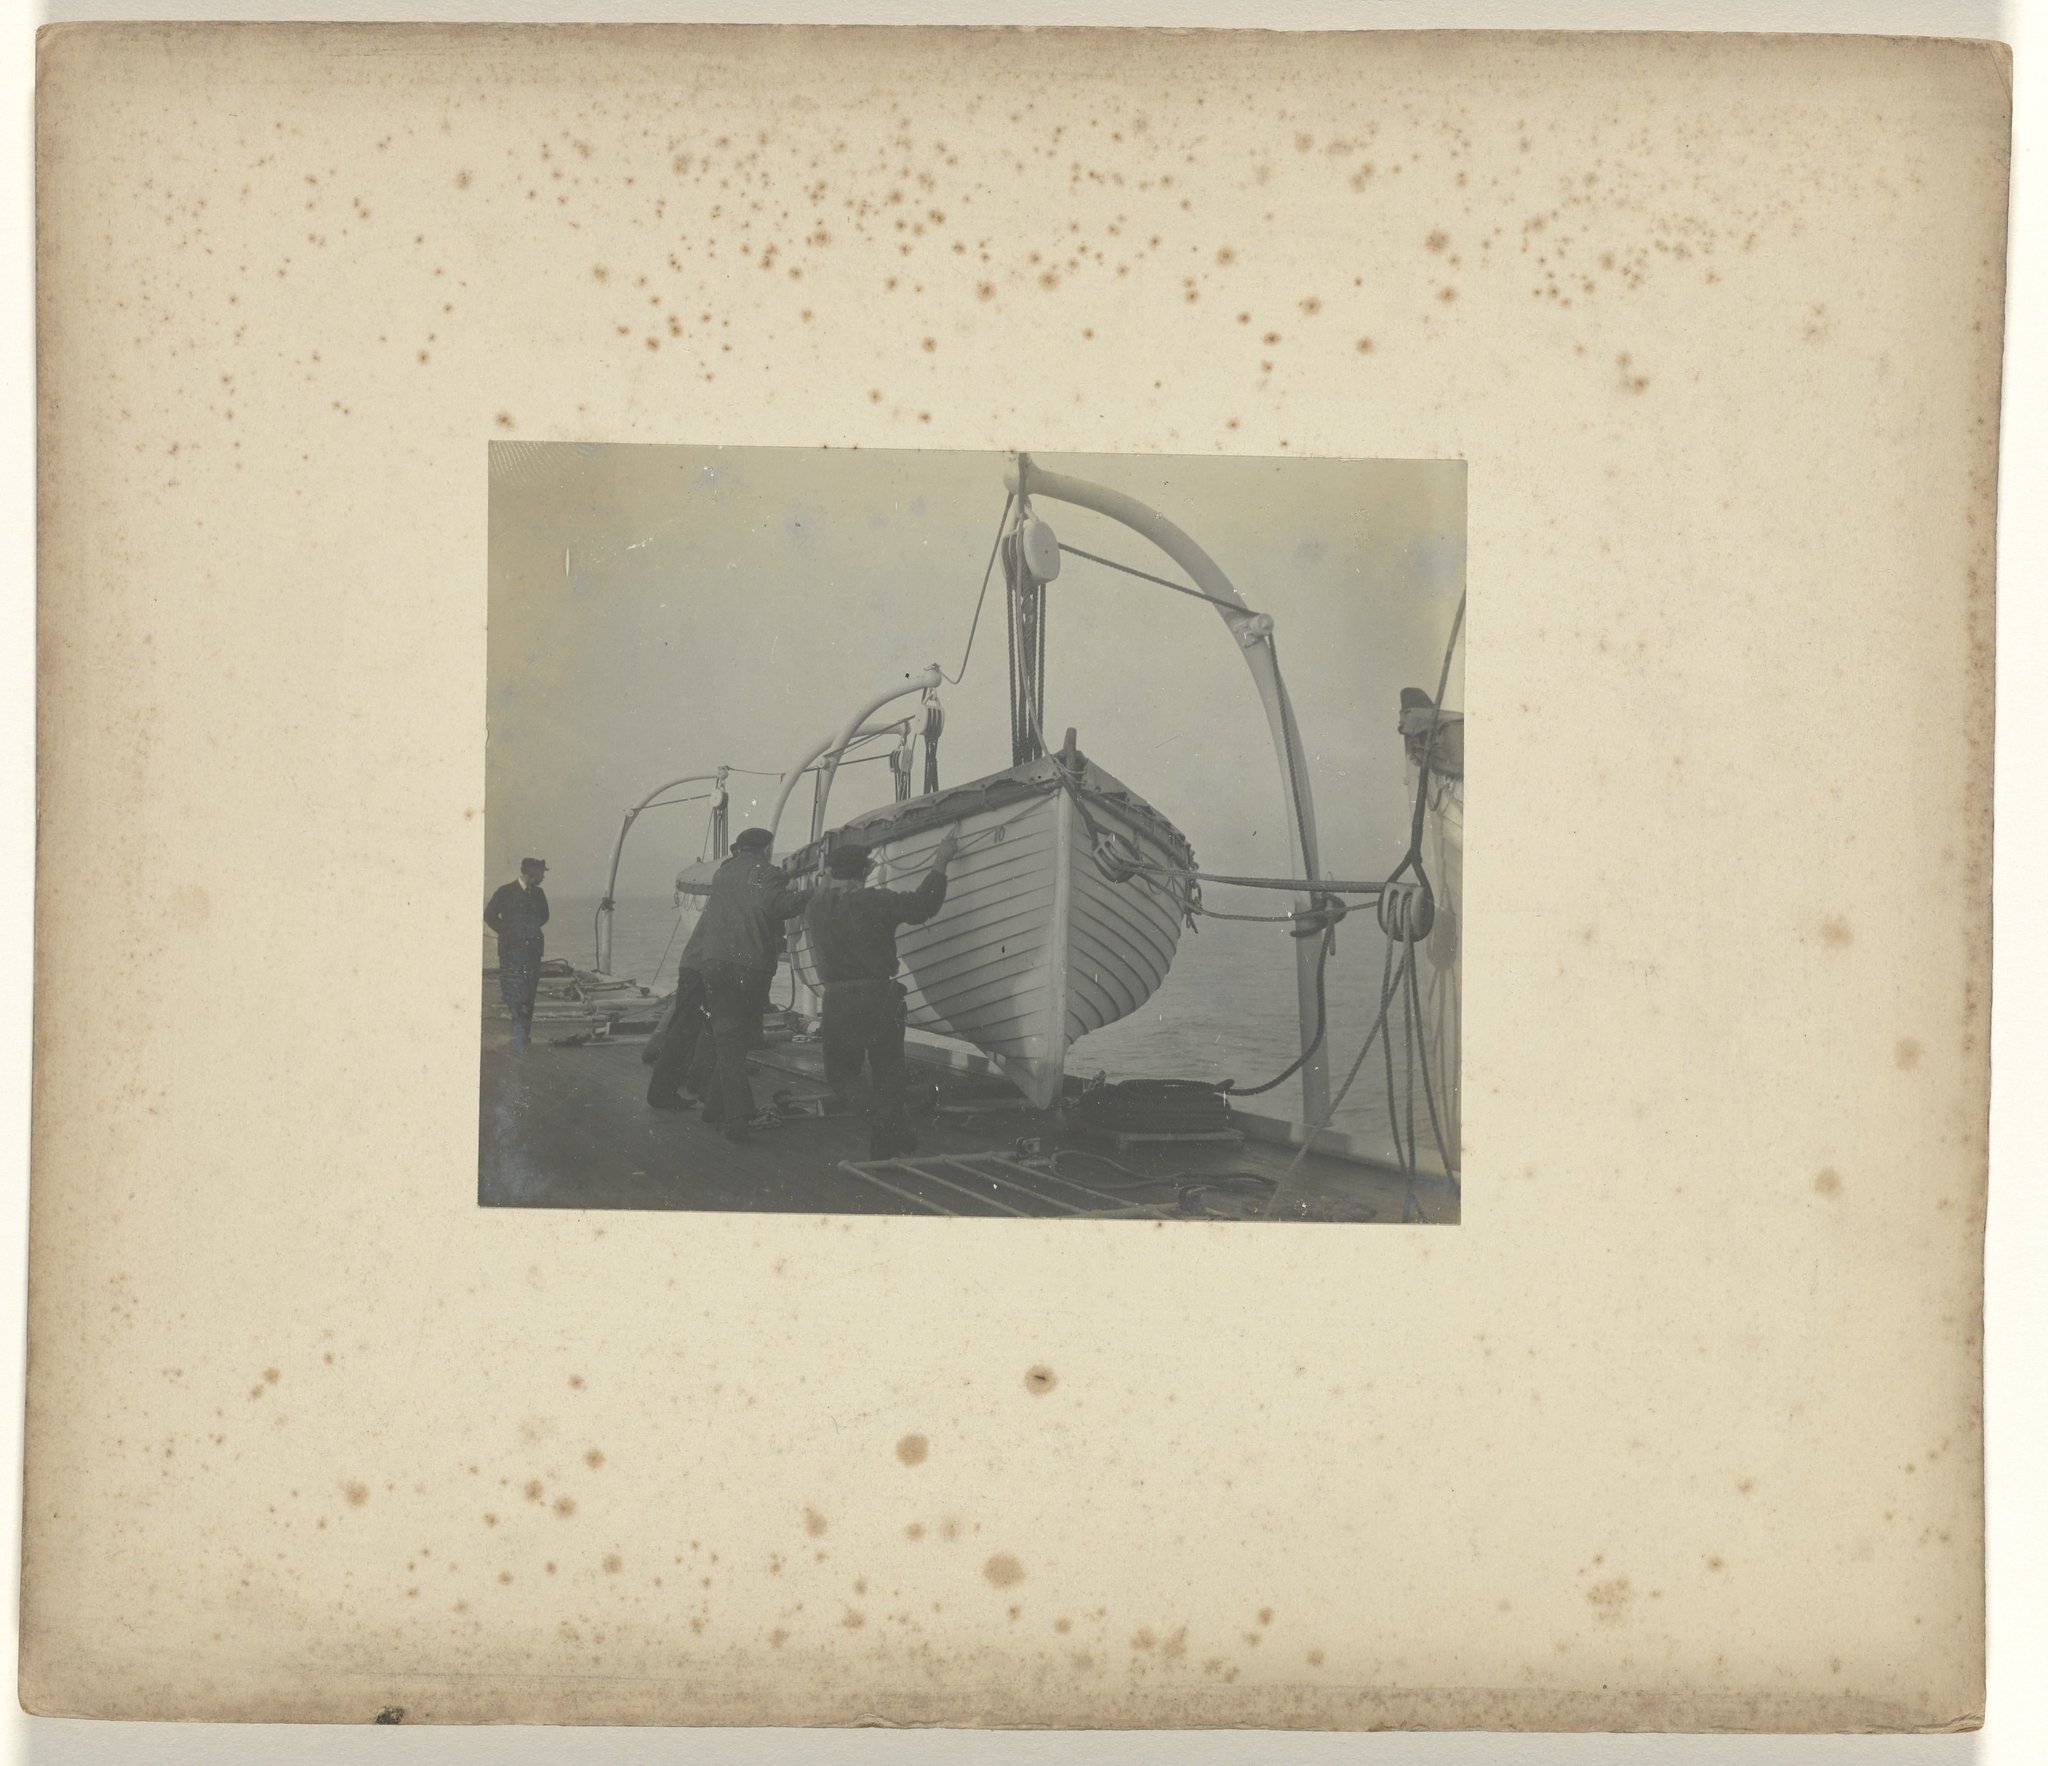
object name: photograph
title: Reddingssloep op het dek van een schip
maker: jan schüller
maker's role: draughtsman, painter, print maker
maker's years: 1871-1915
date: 1904-1905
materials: cardboard, paper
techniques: gelatin silver print